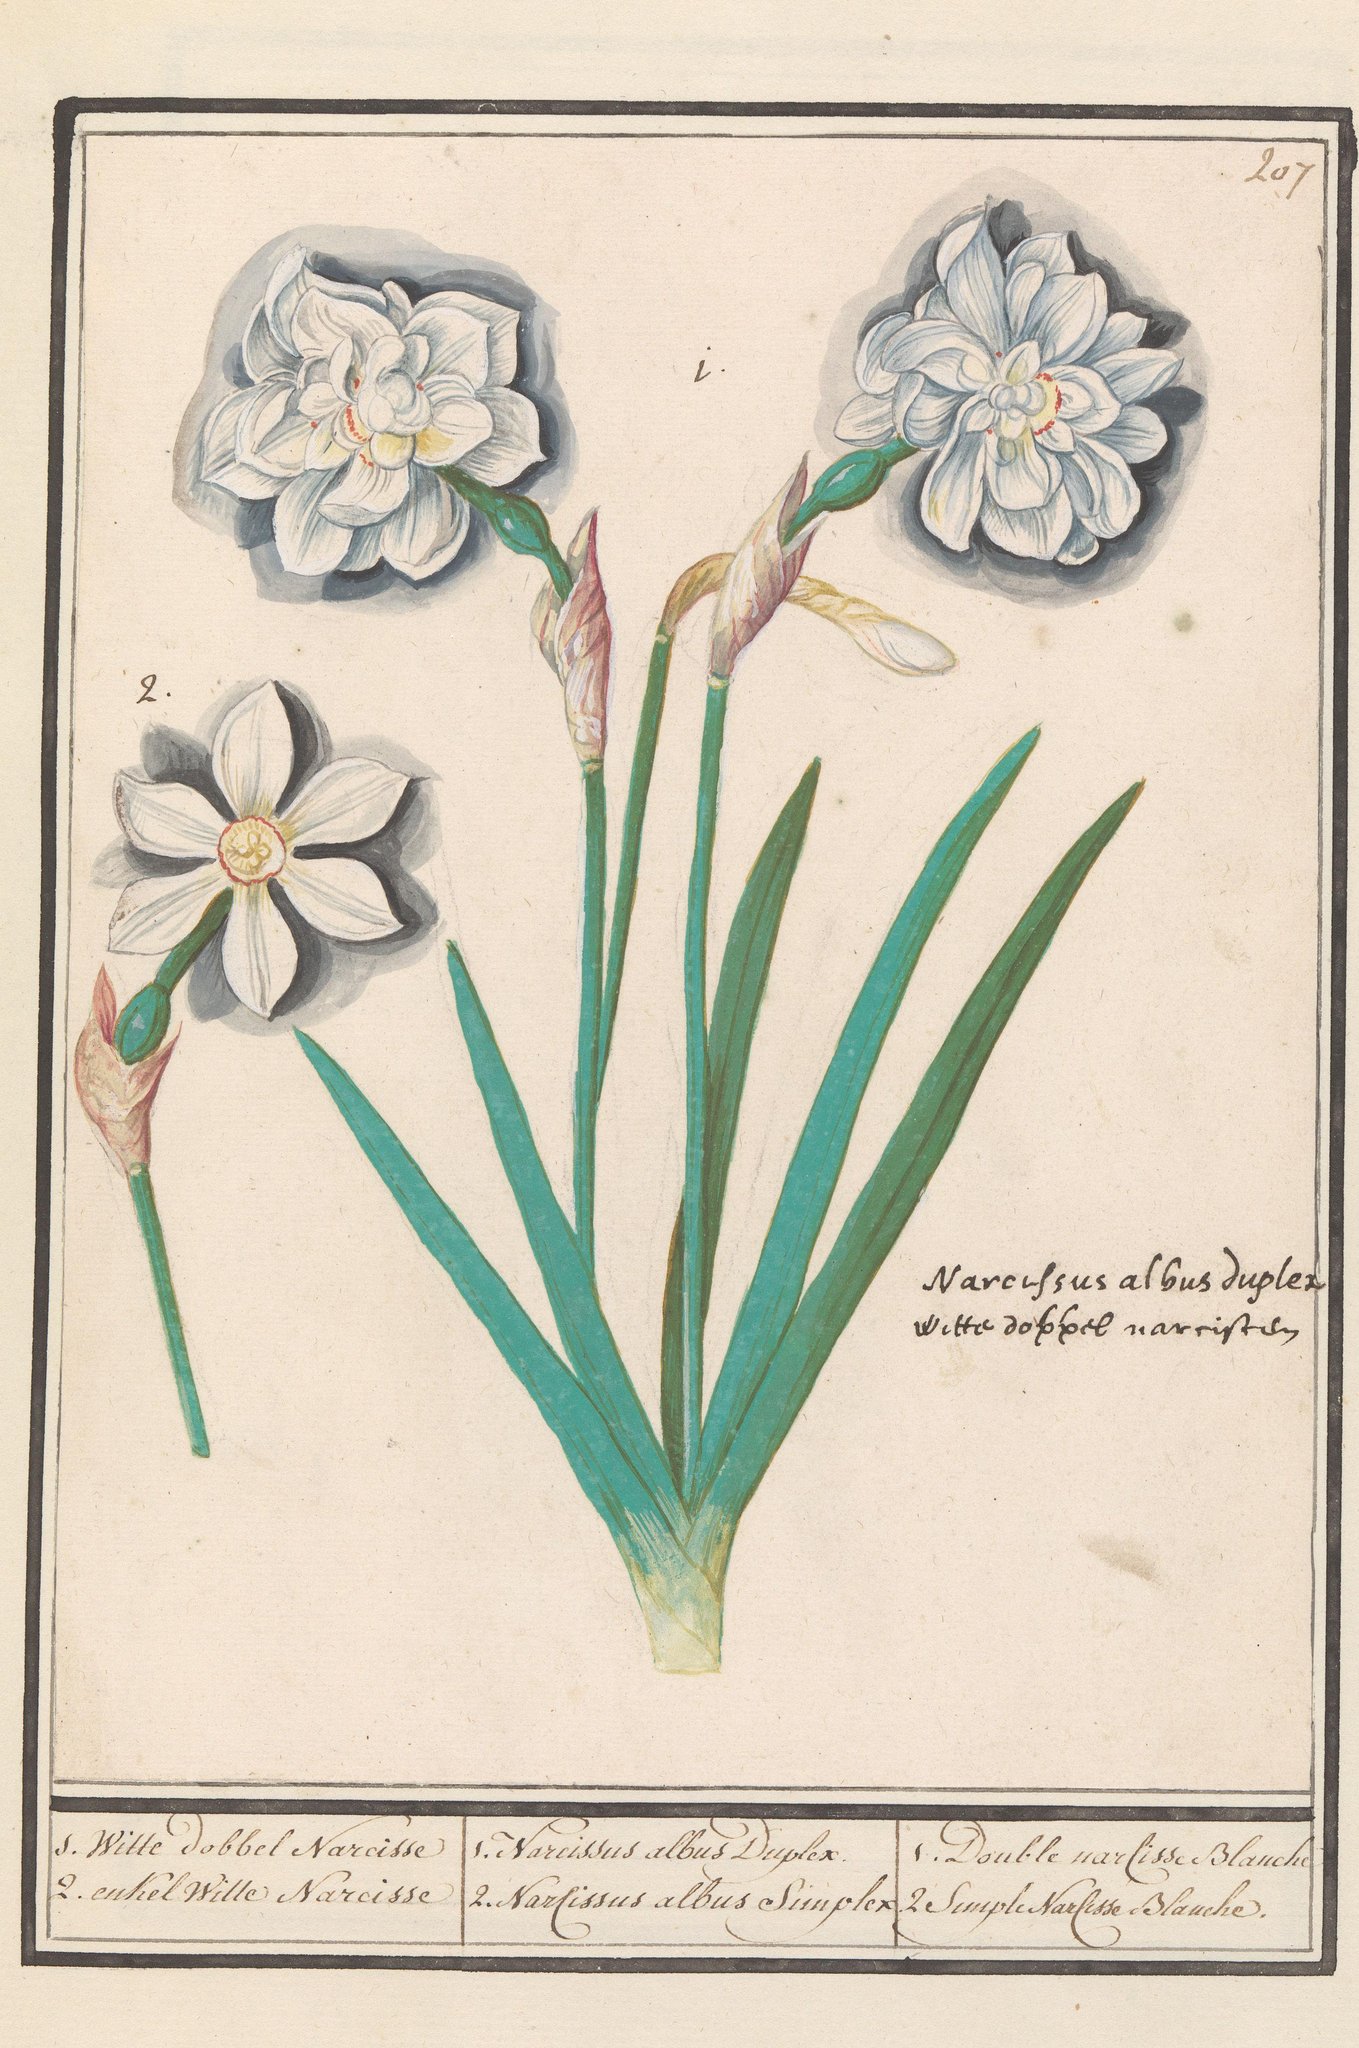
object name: drawing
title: Witte narcis (Narcissus)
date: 1596-1610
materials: chalk, paint, ink, paper, watercolor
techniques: brush, pen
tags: flowers: narcissus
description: Witte narcissen, enkelvoudige en dubbele bloemen. Genummerd rechtsboven: 207. Rechtsonder de Latijnse en Nederlandse naam. Onderdeel van het derde album met tekeningen van bloemen en planten. Tiende van twaalf albums met tekeningen van dieren, vogels en planten bekend rond 1600, gemaakt in opdracht van keizer Rudolf II. Met toelichting in Nederlands, Latijn en Frans.